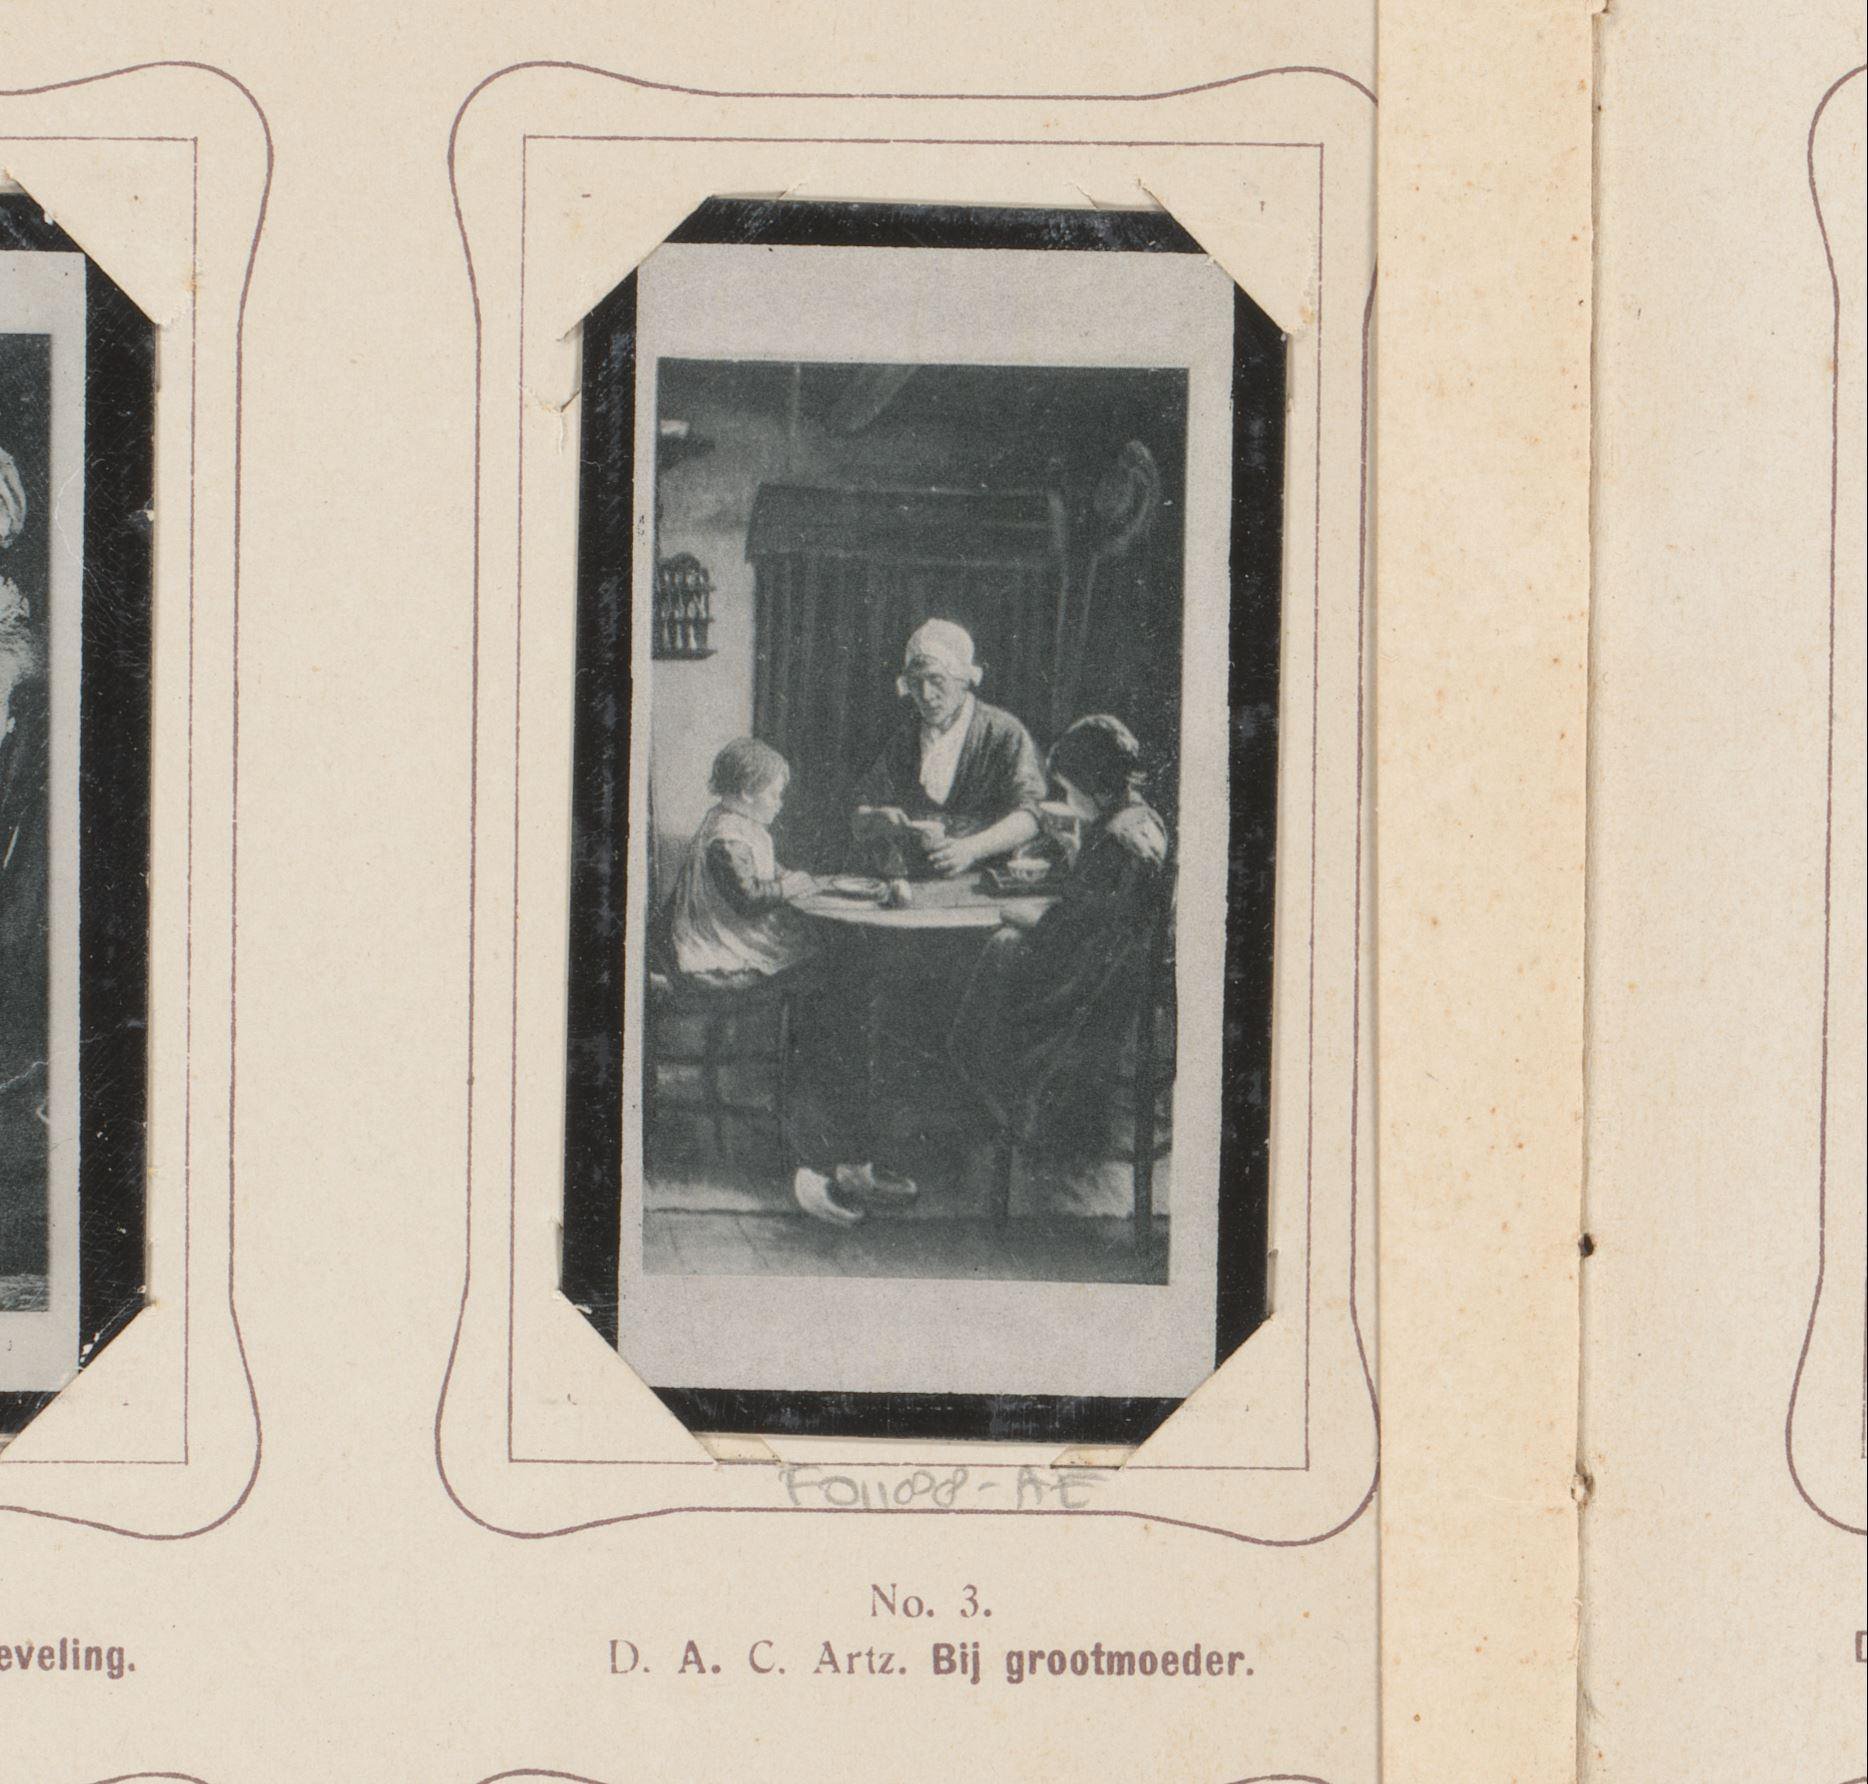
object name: reproduction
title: Reproductie van een schilderij van een oma met twee kleinkinderen aan tafel naar David Adolphe Constant Artz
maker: Anonymous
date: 1906-1907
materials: paper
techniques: photograph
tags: grandparent(s) with grandchild(ren) (family group)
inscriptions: inscription: ‘No. 3./ D.A.C. Artz. Bij grootmoeder.’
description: Deze prent maakt deel uit van een album.